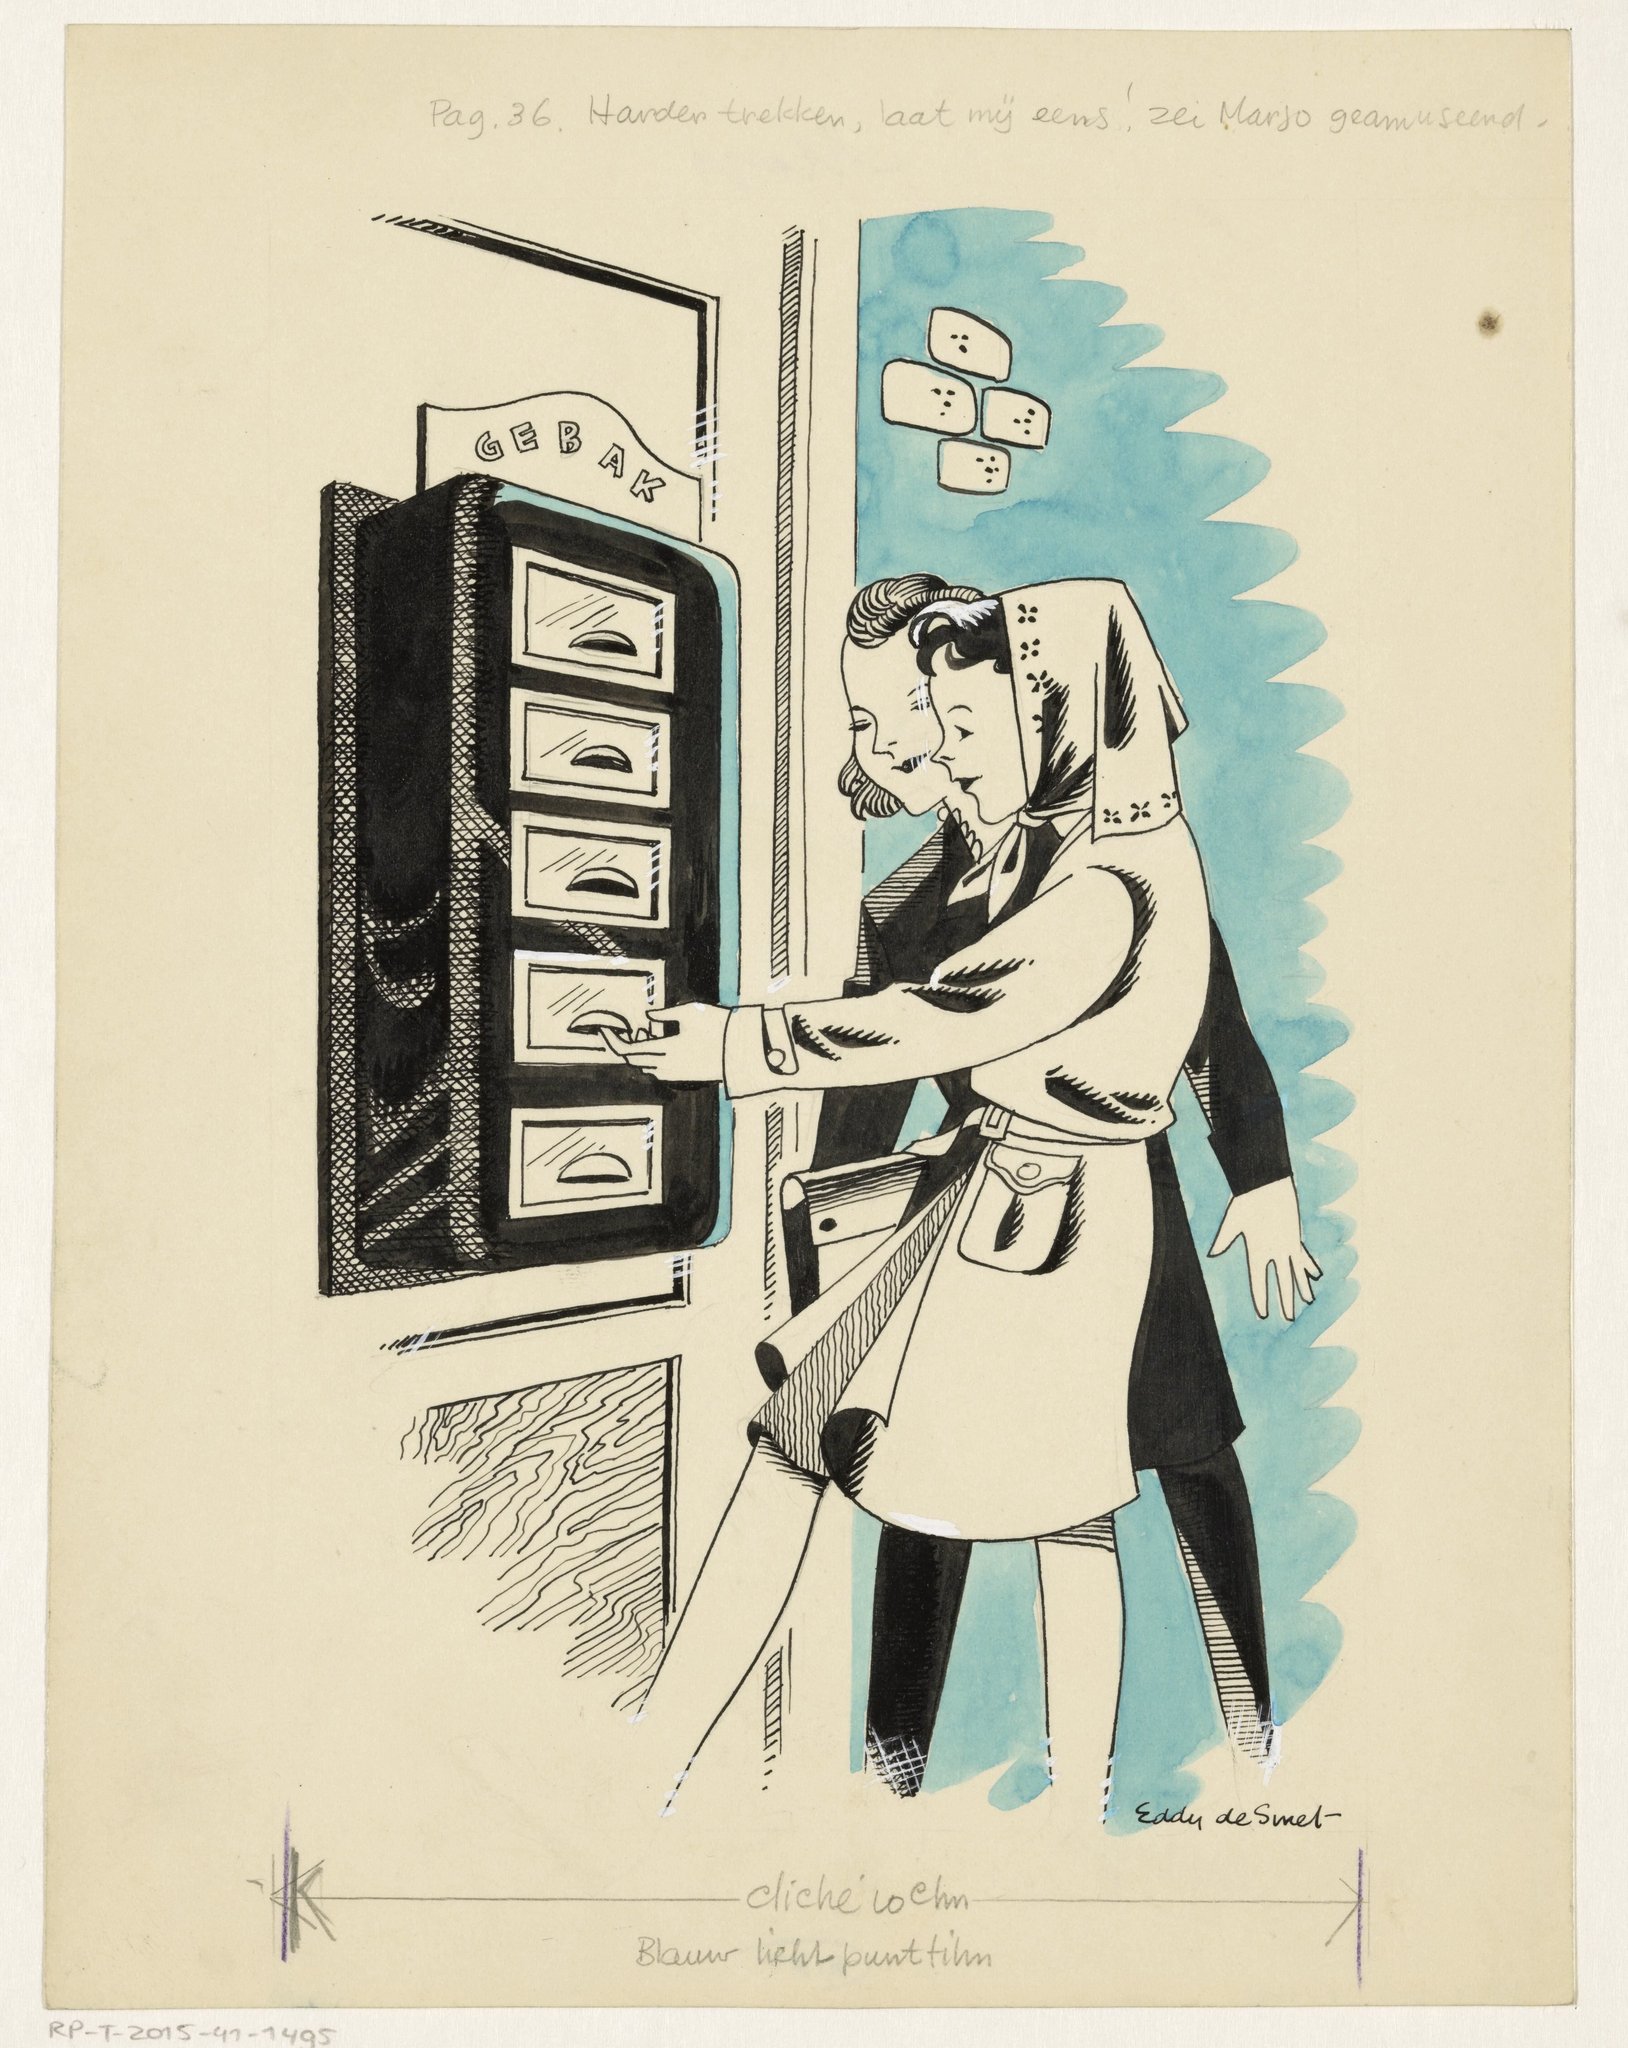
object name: drawing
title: Marjo bij een loket met gebak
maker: eddy de smet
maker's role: draughtsman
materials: paint, ink, paper, pencil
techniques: brush, pen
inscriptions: :, annotation: ‘Pag. 36. Harder trekken, laat mij eens! zei Marjo geamuseerd.’, signature: ‘Eddy de Smet’, collector's mark: Lugt 2228, annotation: ‘Marjo’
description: Marjo en een jonge vrouw staan bij een loket in een muur. Het loket bestaat uit vijf lades met een greepje. Boven het loket staat 'Gebak'. Marjo trekt aan een greepje van één van de lades.